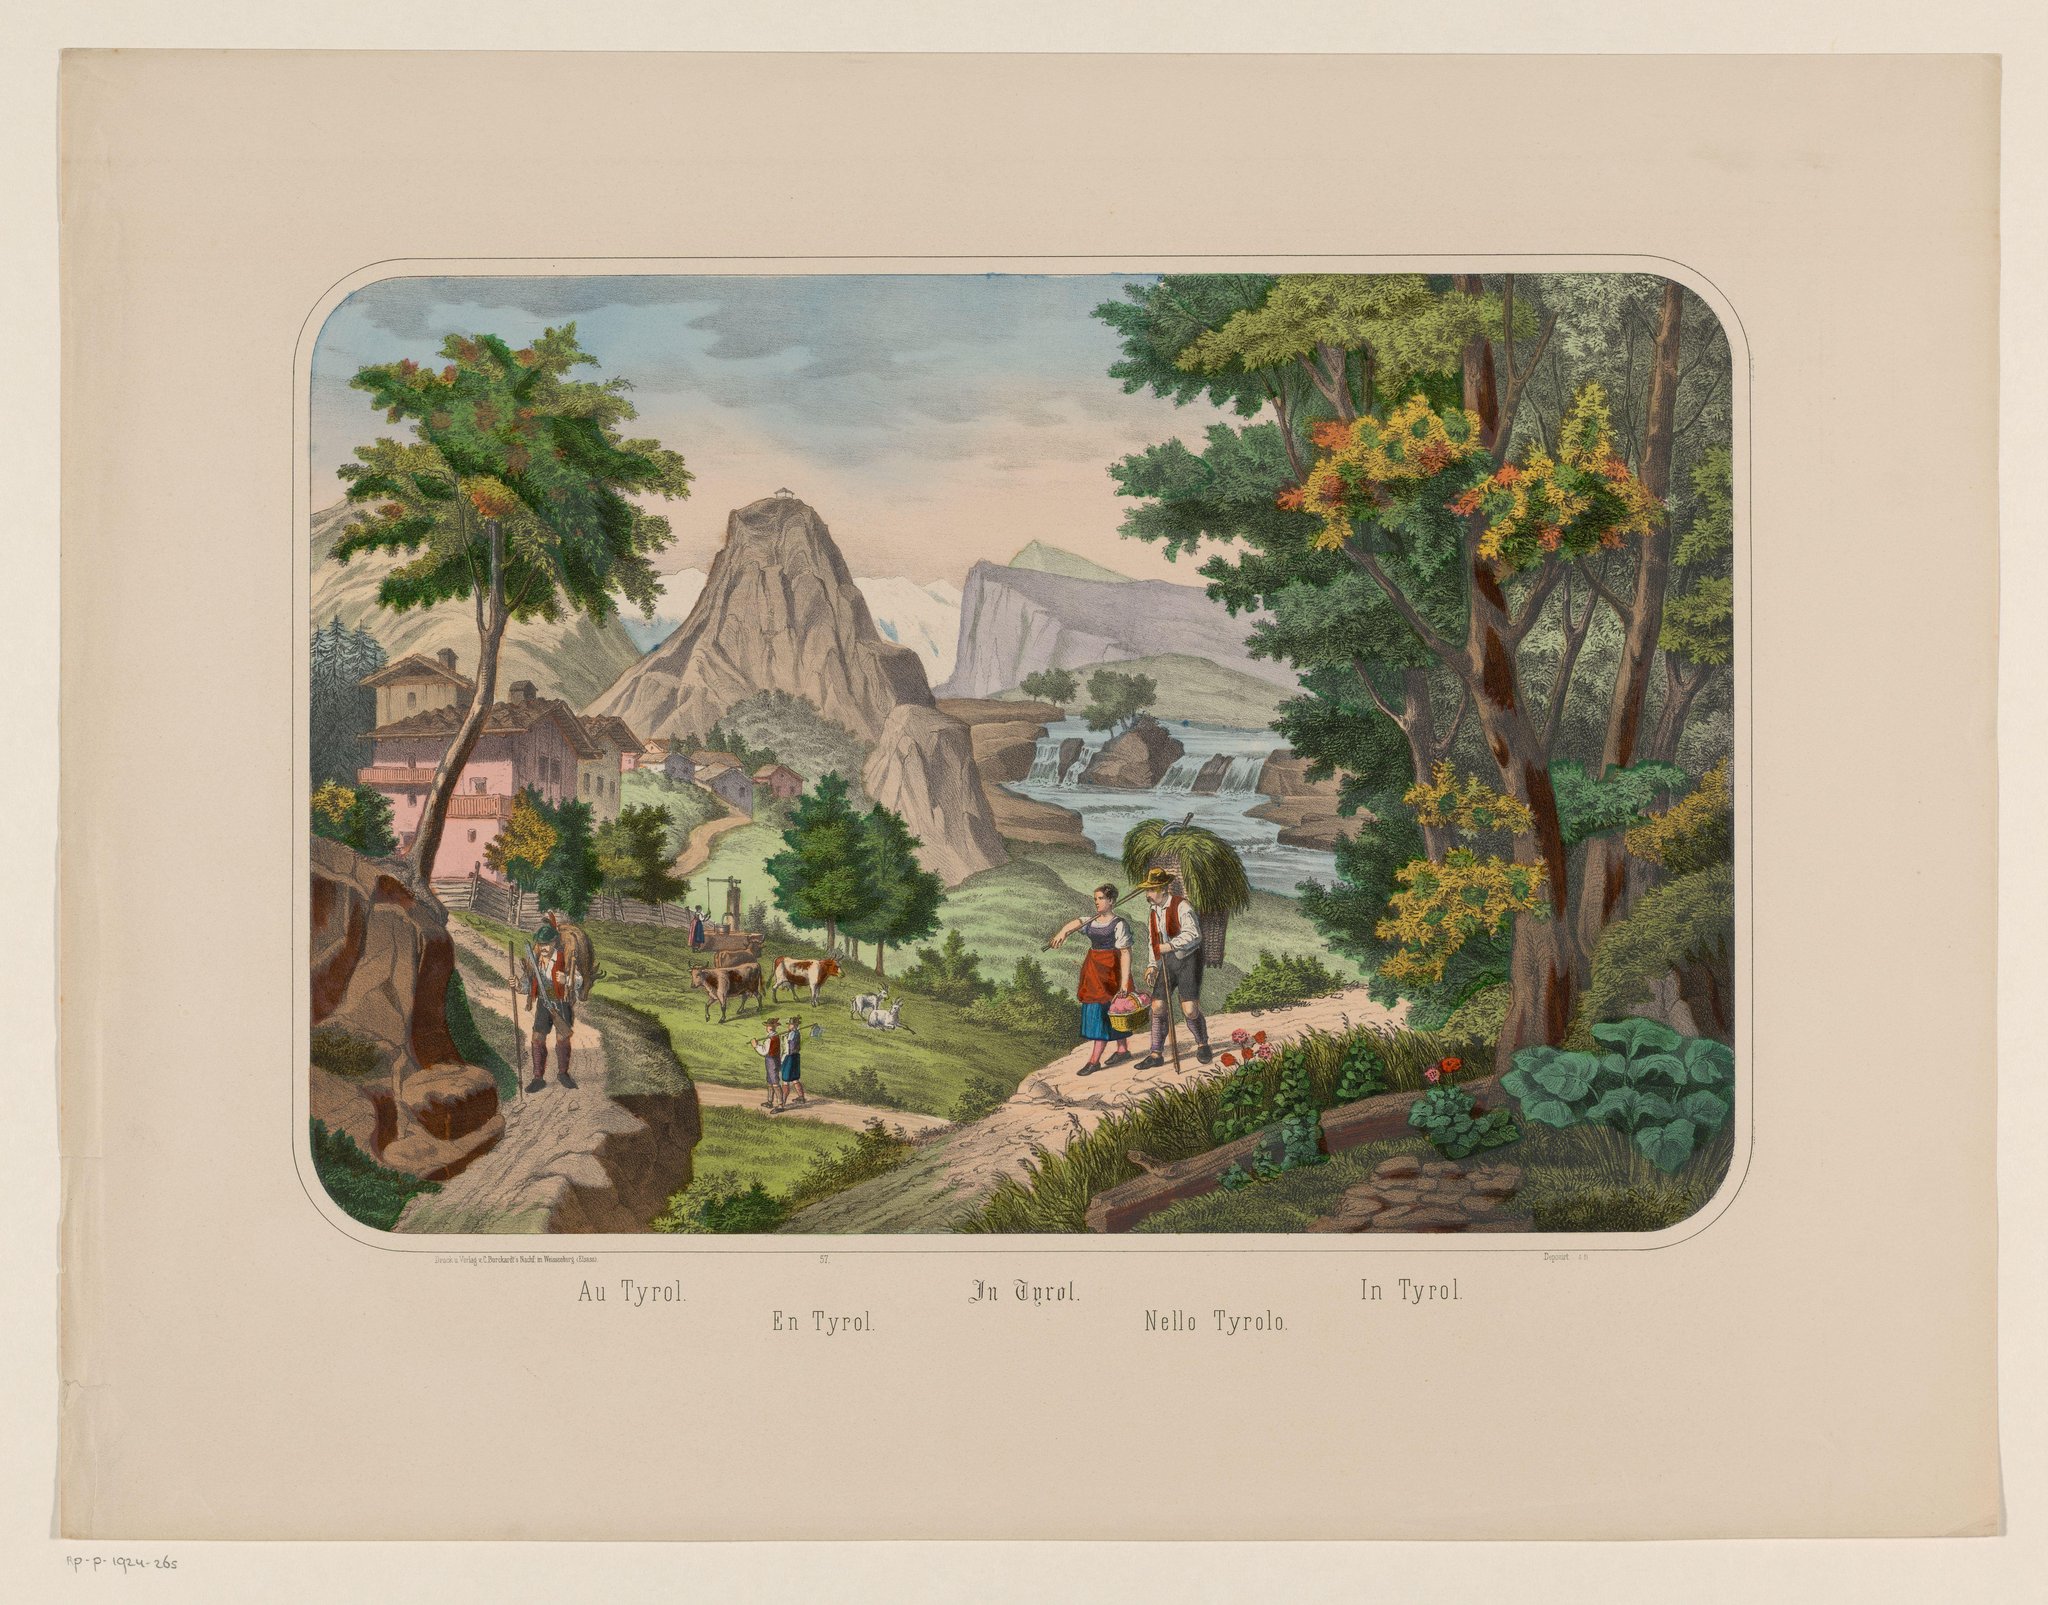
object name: print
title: Au Tyrol / En Tyrol / In Tyrol / Nello Tyrolo / In Tyrol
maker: Anonymous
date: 1889-1906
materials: paper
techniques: lithograph, hand coloring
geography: weissenburg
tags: river, farmers, return from the hunt, mountains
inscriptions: collector's mark: Lugt 2233